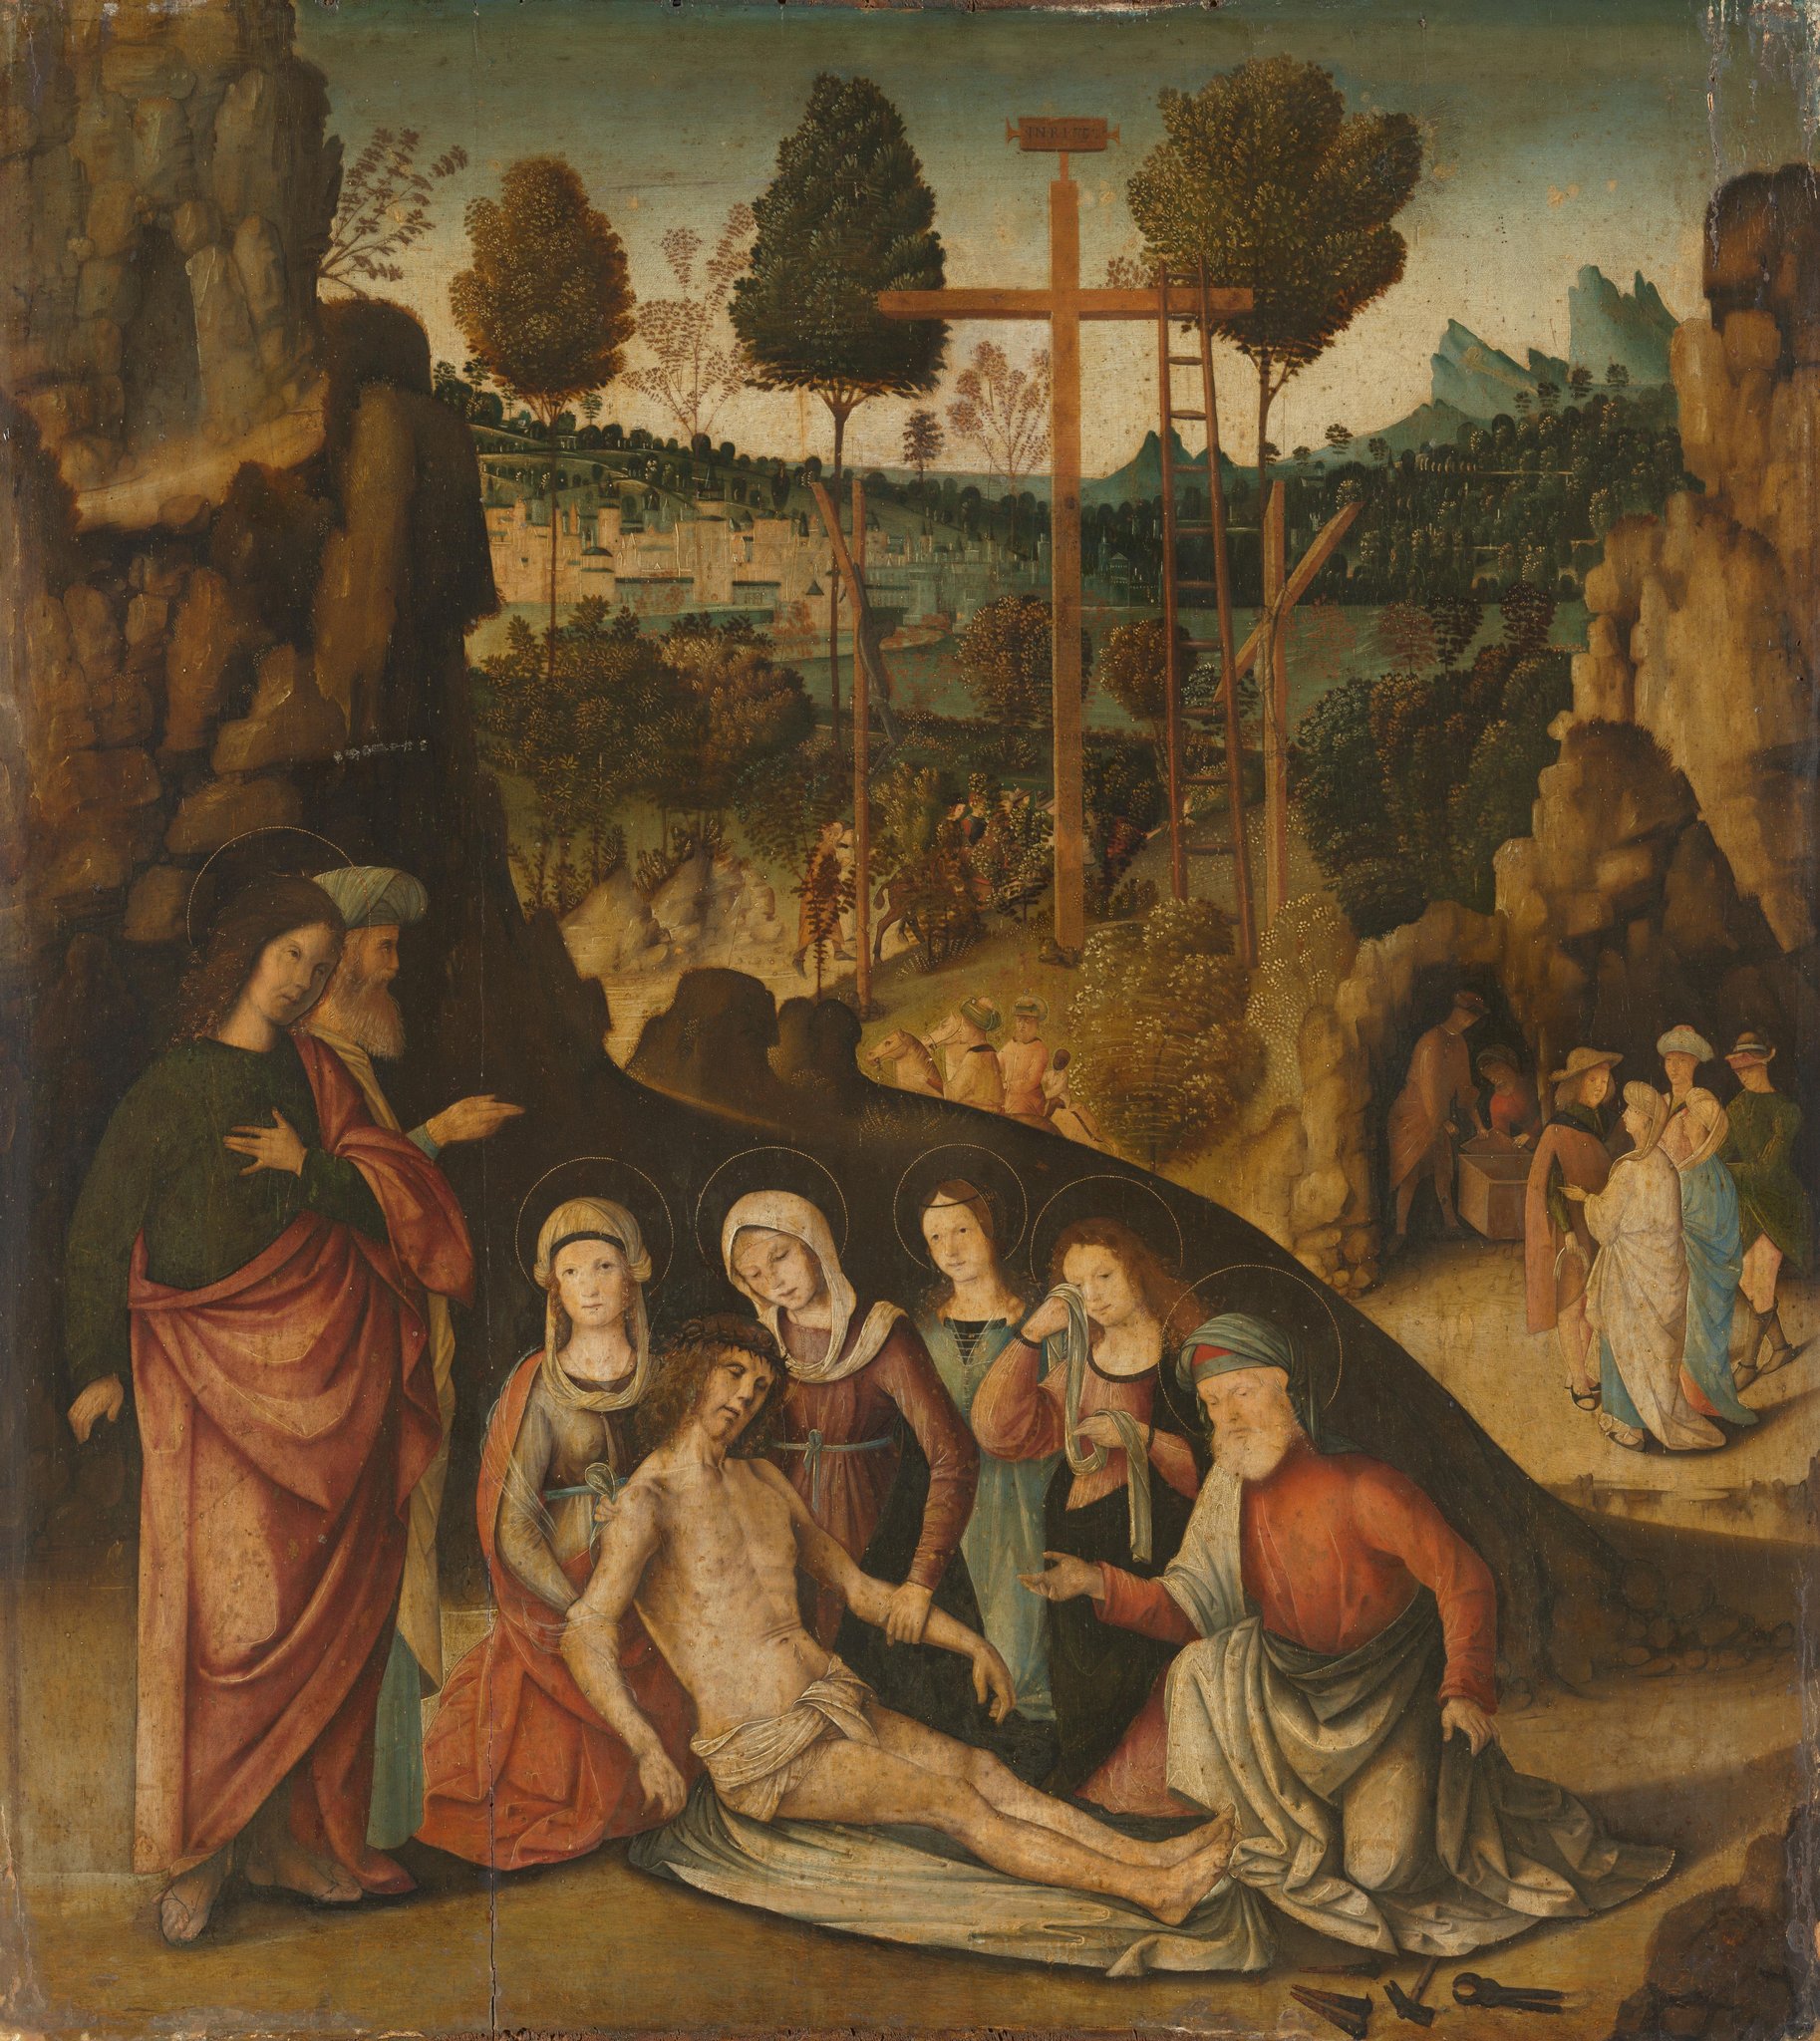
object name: painting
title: Lamentation of Christ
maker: bernardino zaganelli di bosio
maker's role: painter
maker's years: 1460-1512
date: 1470-1520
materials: oil, panel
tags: christ's body lying on the ground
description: De bewening van Christus. In een landschap knielen de heilige vrouwen en Jozef van Arimathea bij het lichaam van Christus. Rechts staan Johannes en Nikodemus. Op de achtergrond het lege kruis en een groep figuren rond het geopende lege graf.